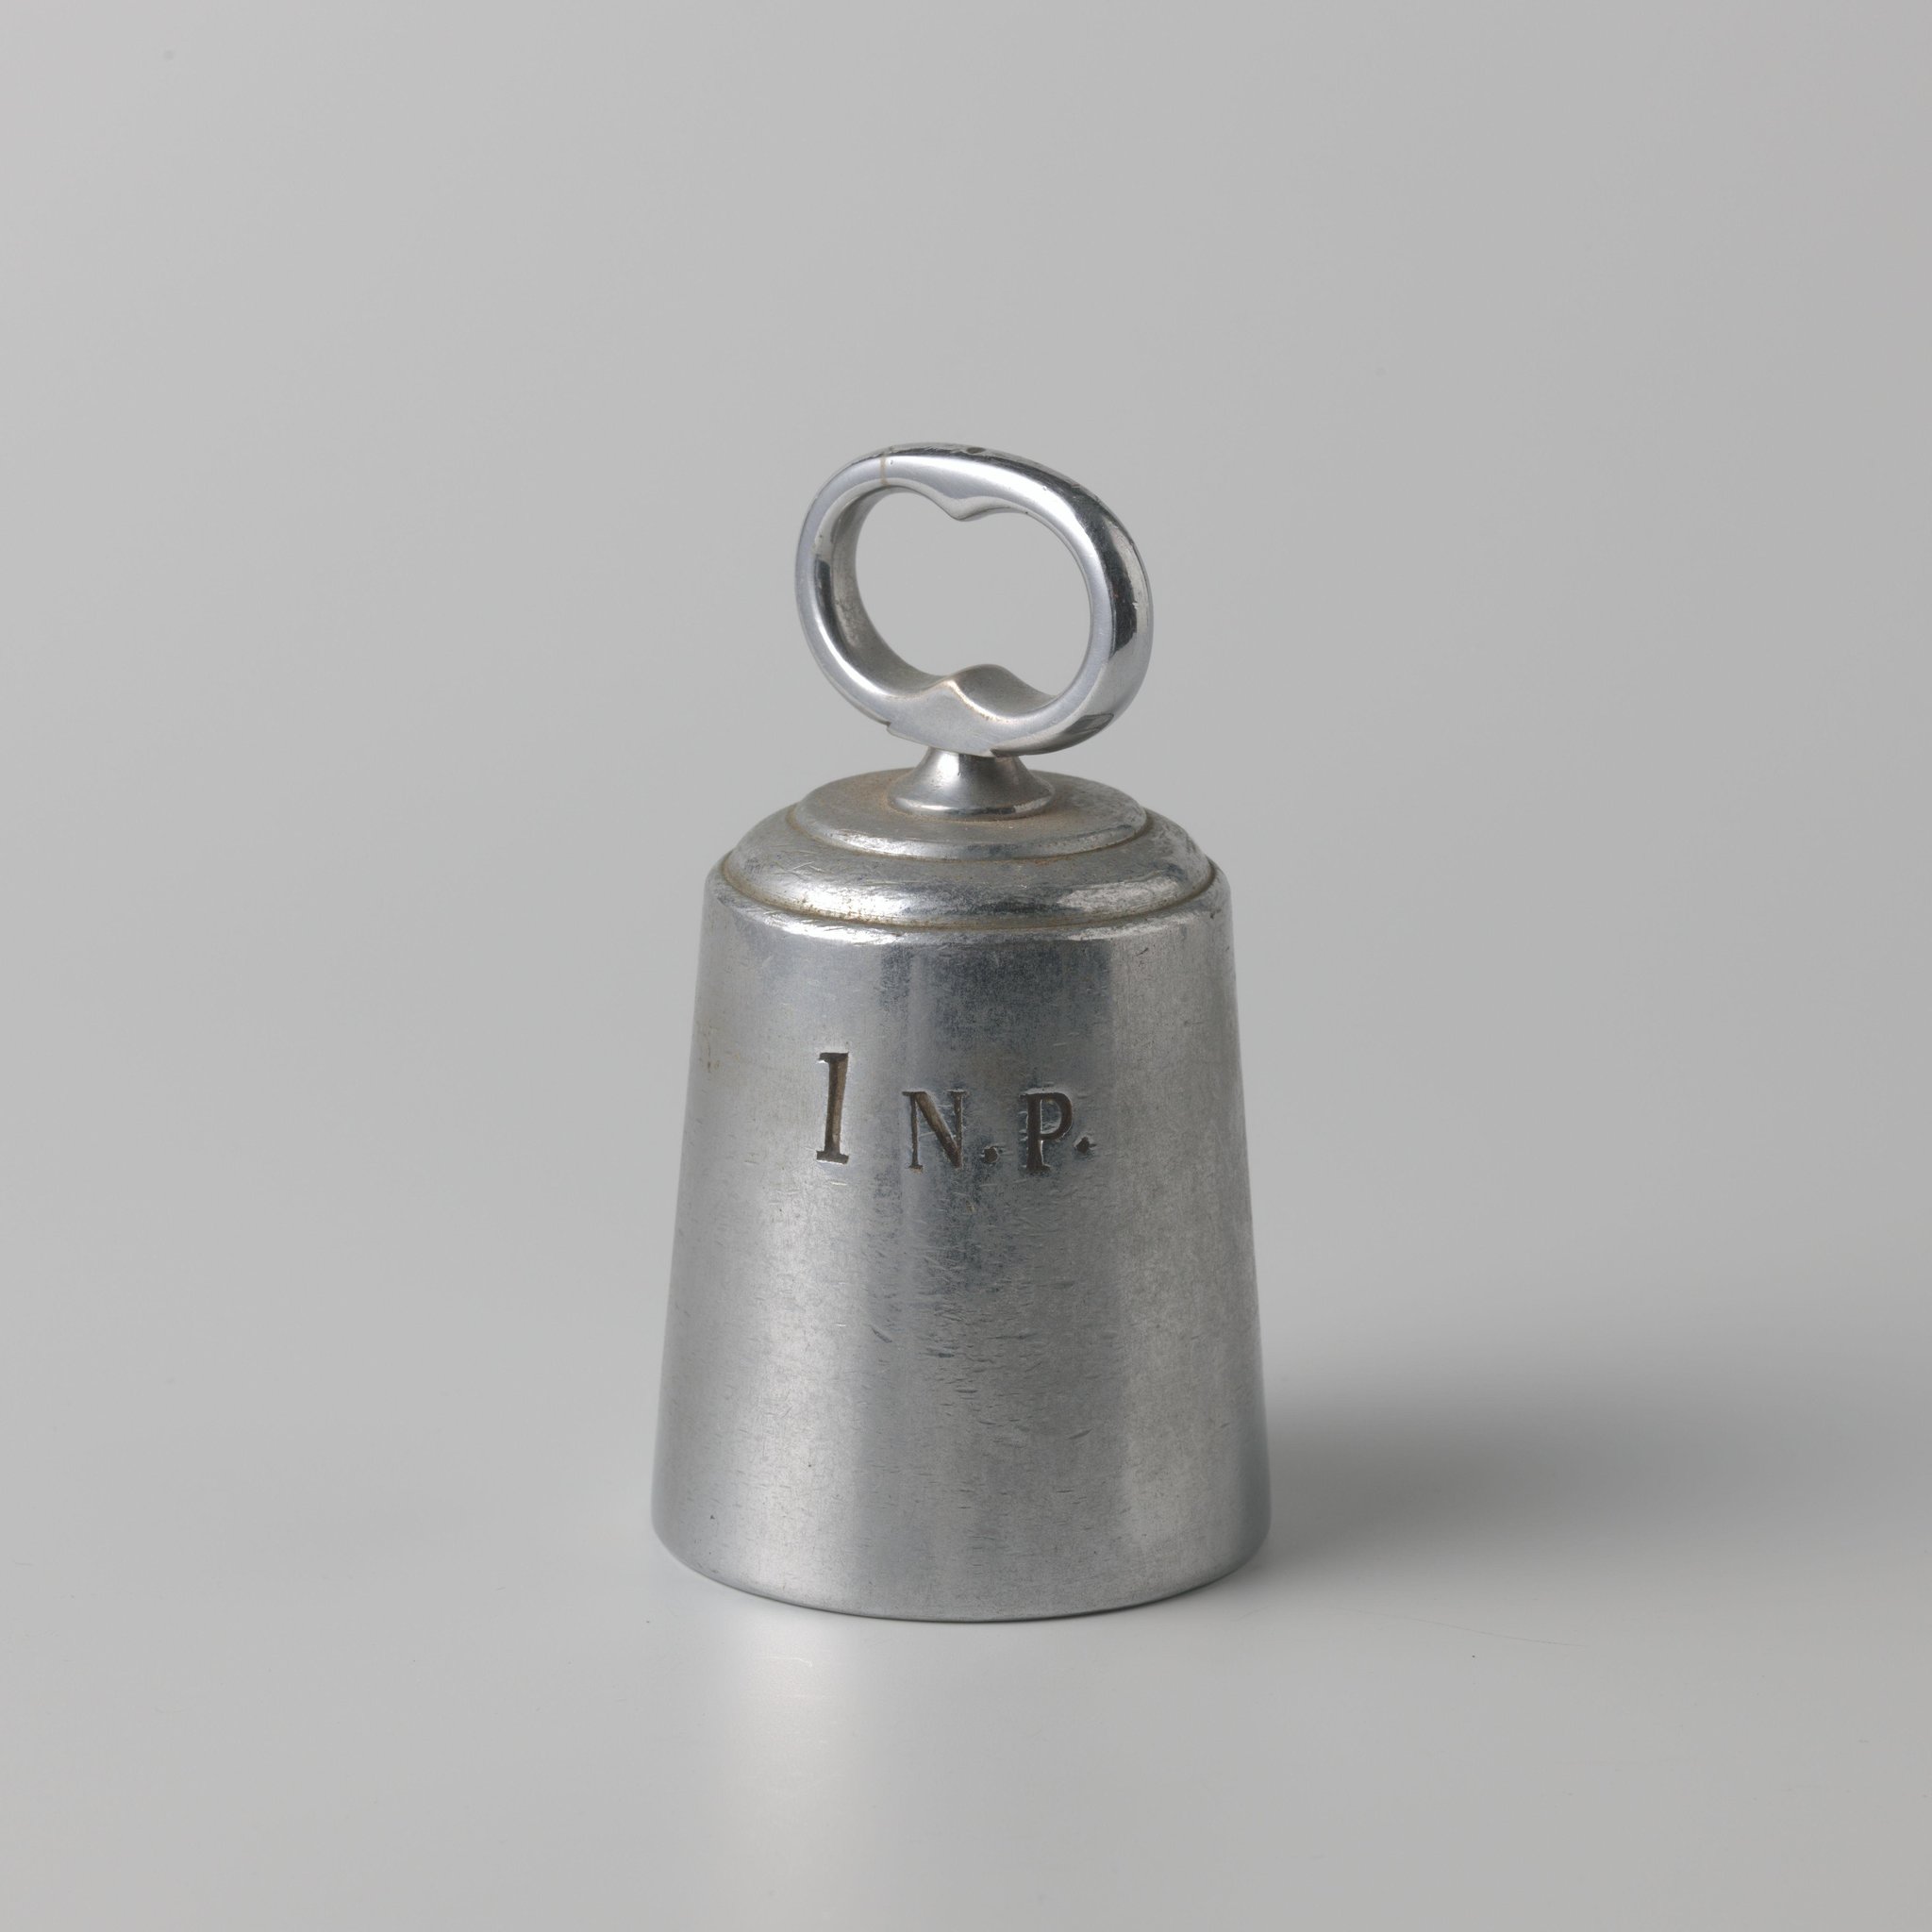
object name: ijkgewicht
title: IJkgewicht voor de Nederlandse Pond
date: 1851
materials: iron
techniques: chroming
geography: the hague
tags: netherlands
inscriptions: mark, mark: ‘1 N.P.’, mark: ‘6.’, inscription: ‘HBI’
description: IJkgewicht, verchroomd gietijzer, 1851. Een ‘Nederlandsch pond’ had de waarde van één kilogram. De naam was vastgesteld bij Koninklijk Besluit (19 maart 1817). Met dit ijkgewicht werden gewichten, die bijvoorbeeld in winkels gebruikt werden, gecontroleerd en eventueel gecorrigeerd. Bruikleen NMi Museum IJkwezen, Delft.